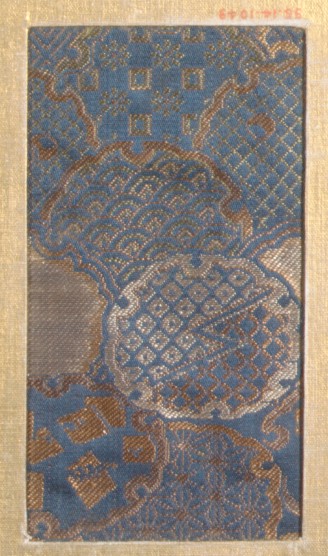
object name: piece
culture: japanese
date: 1701-1900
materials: silk